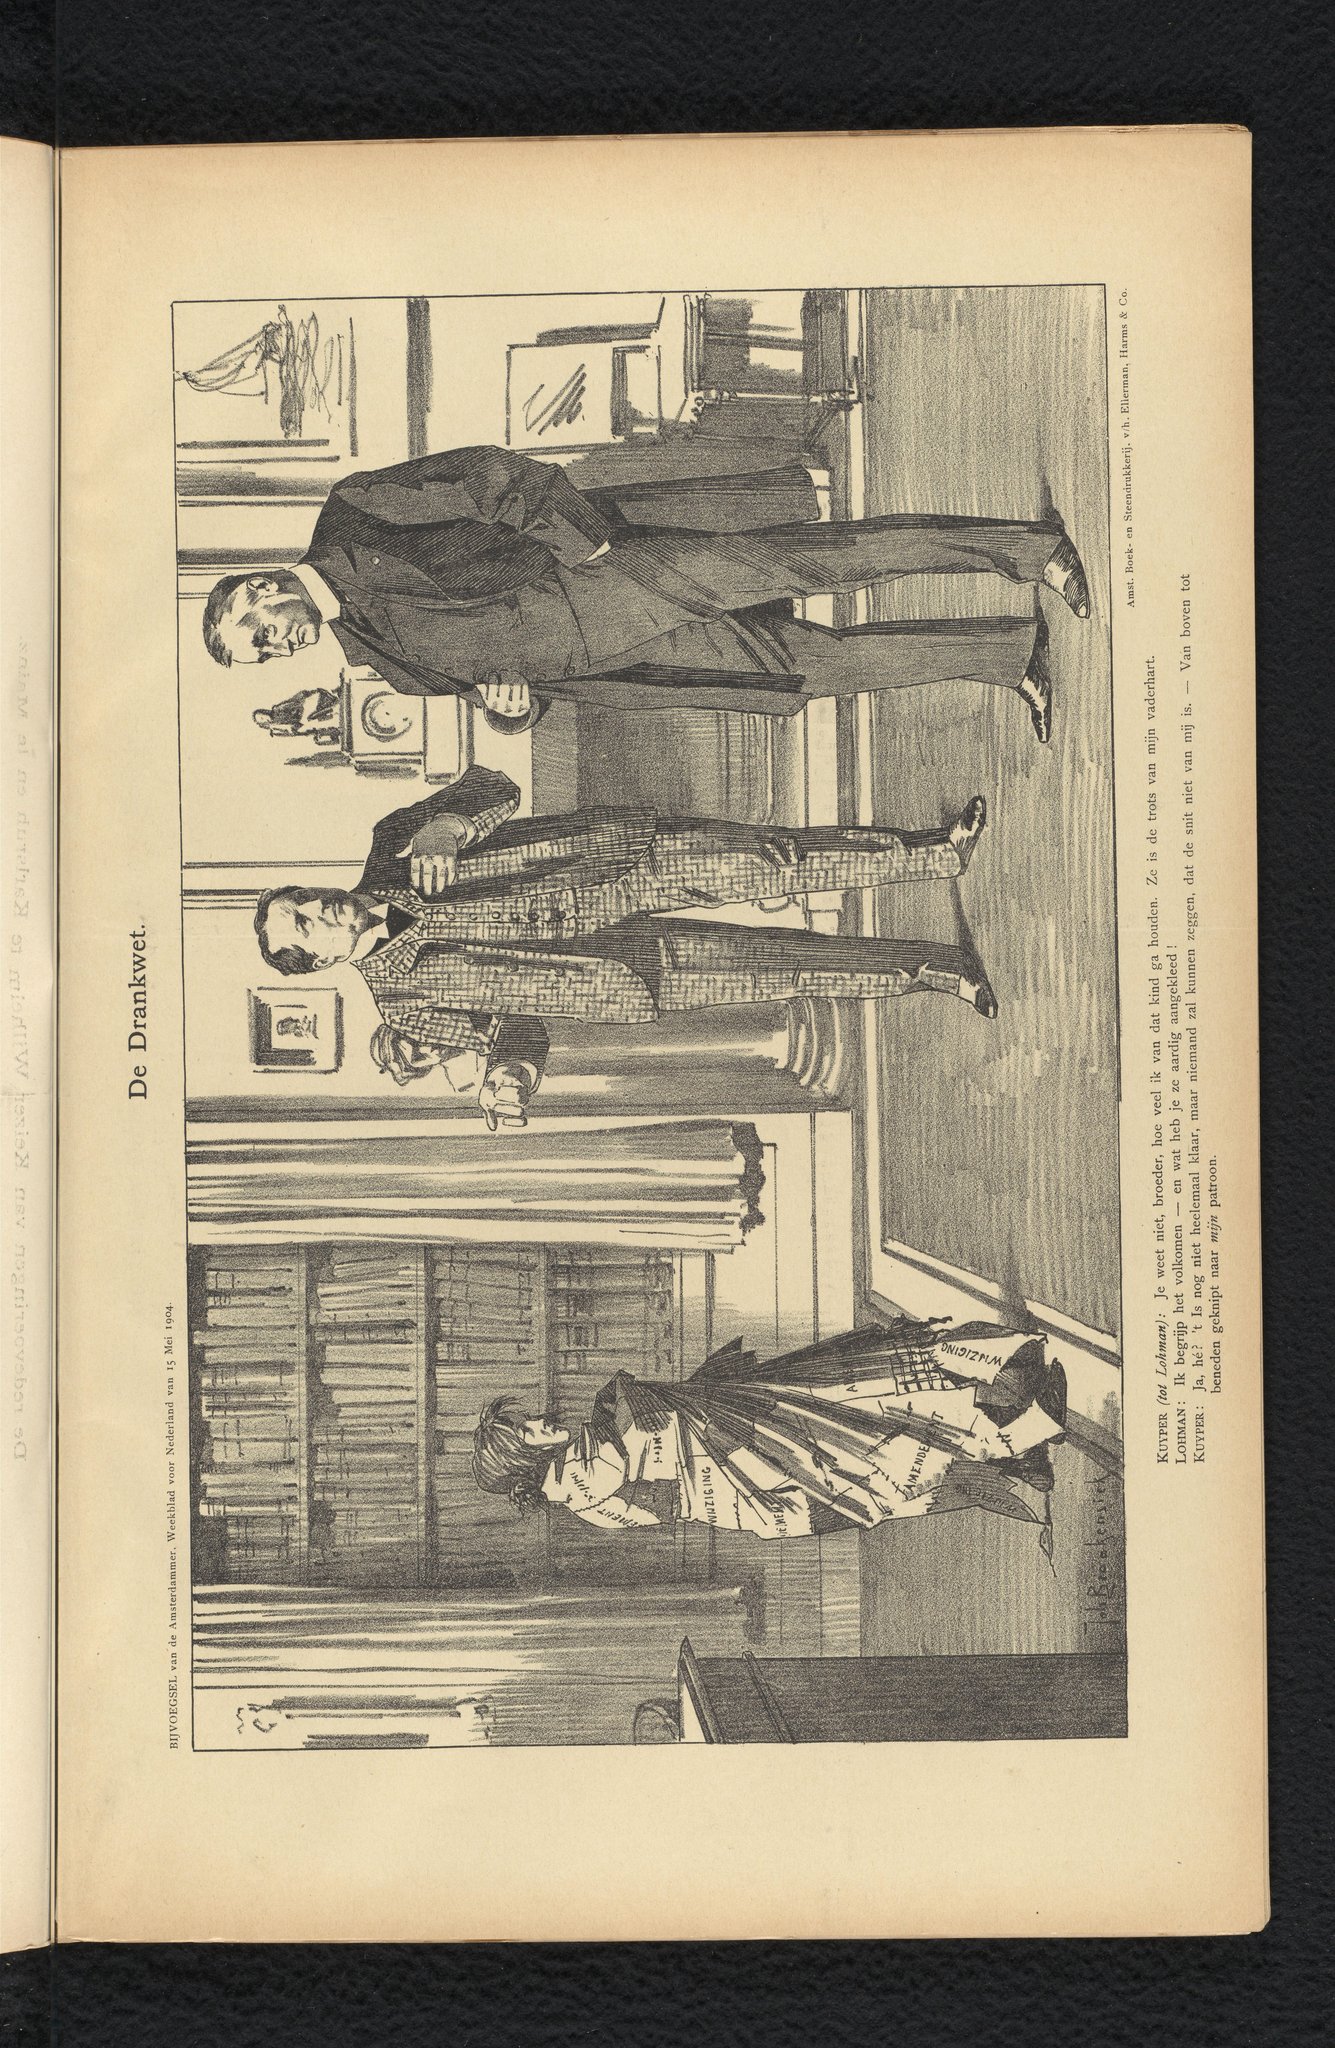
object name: cartoon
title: De Drankwet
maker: johan braakensiek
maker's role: draughtsman, print maker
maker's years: 1858-1940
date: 1904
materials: paper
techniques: lithograph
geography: netherlands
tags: jonkheer alexander frederik de savornin lohman, the hague, abraham kuyper, clothed in rags, the poor, political caricatures and satires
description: Premier Kuyper bespreekt samen met De Savornin Lohman zijn drankwet, voorgesteld als een arm meisje gekleed in een mantel van aaneengestikte lappen.